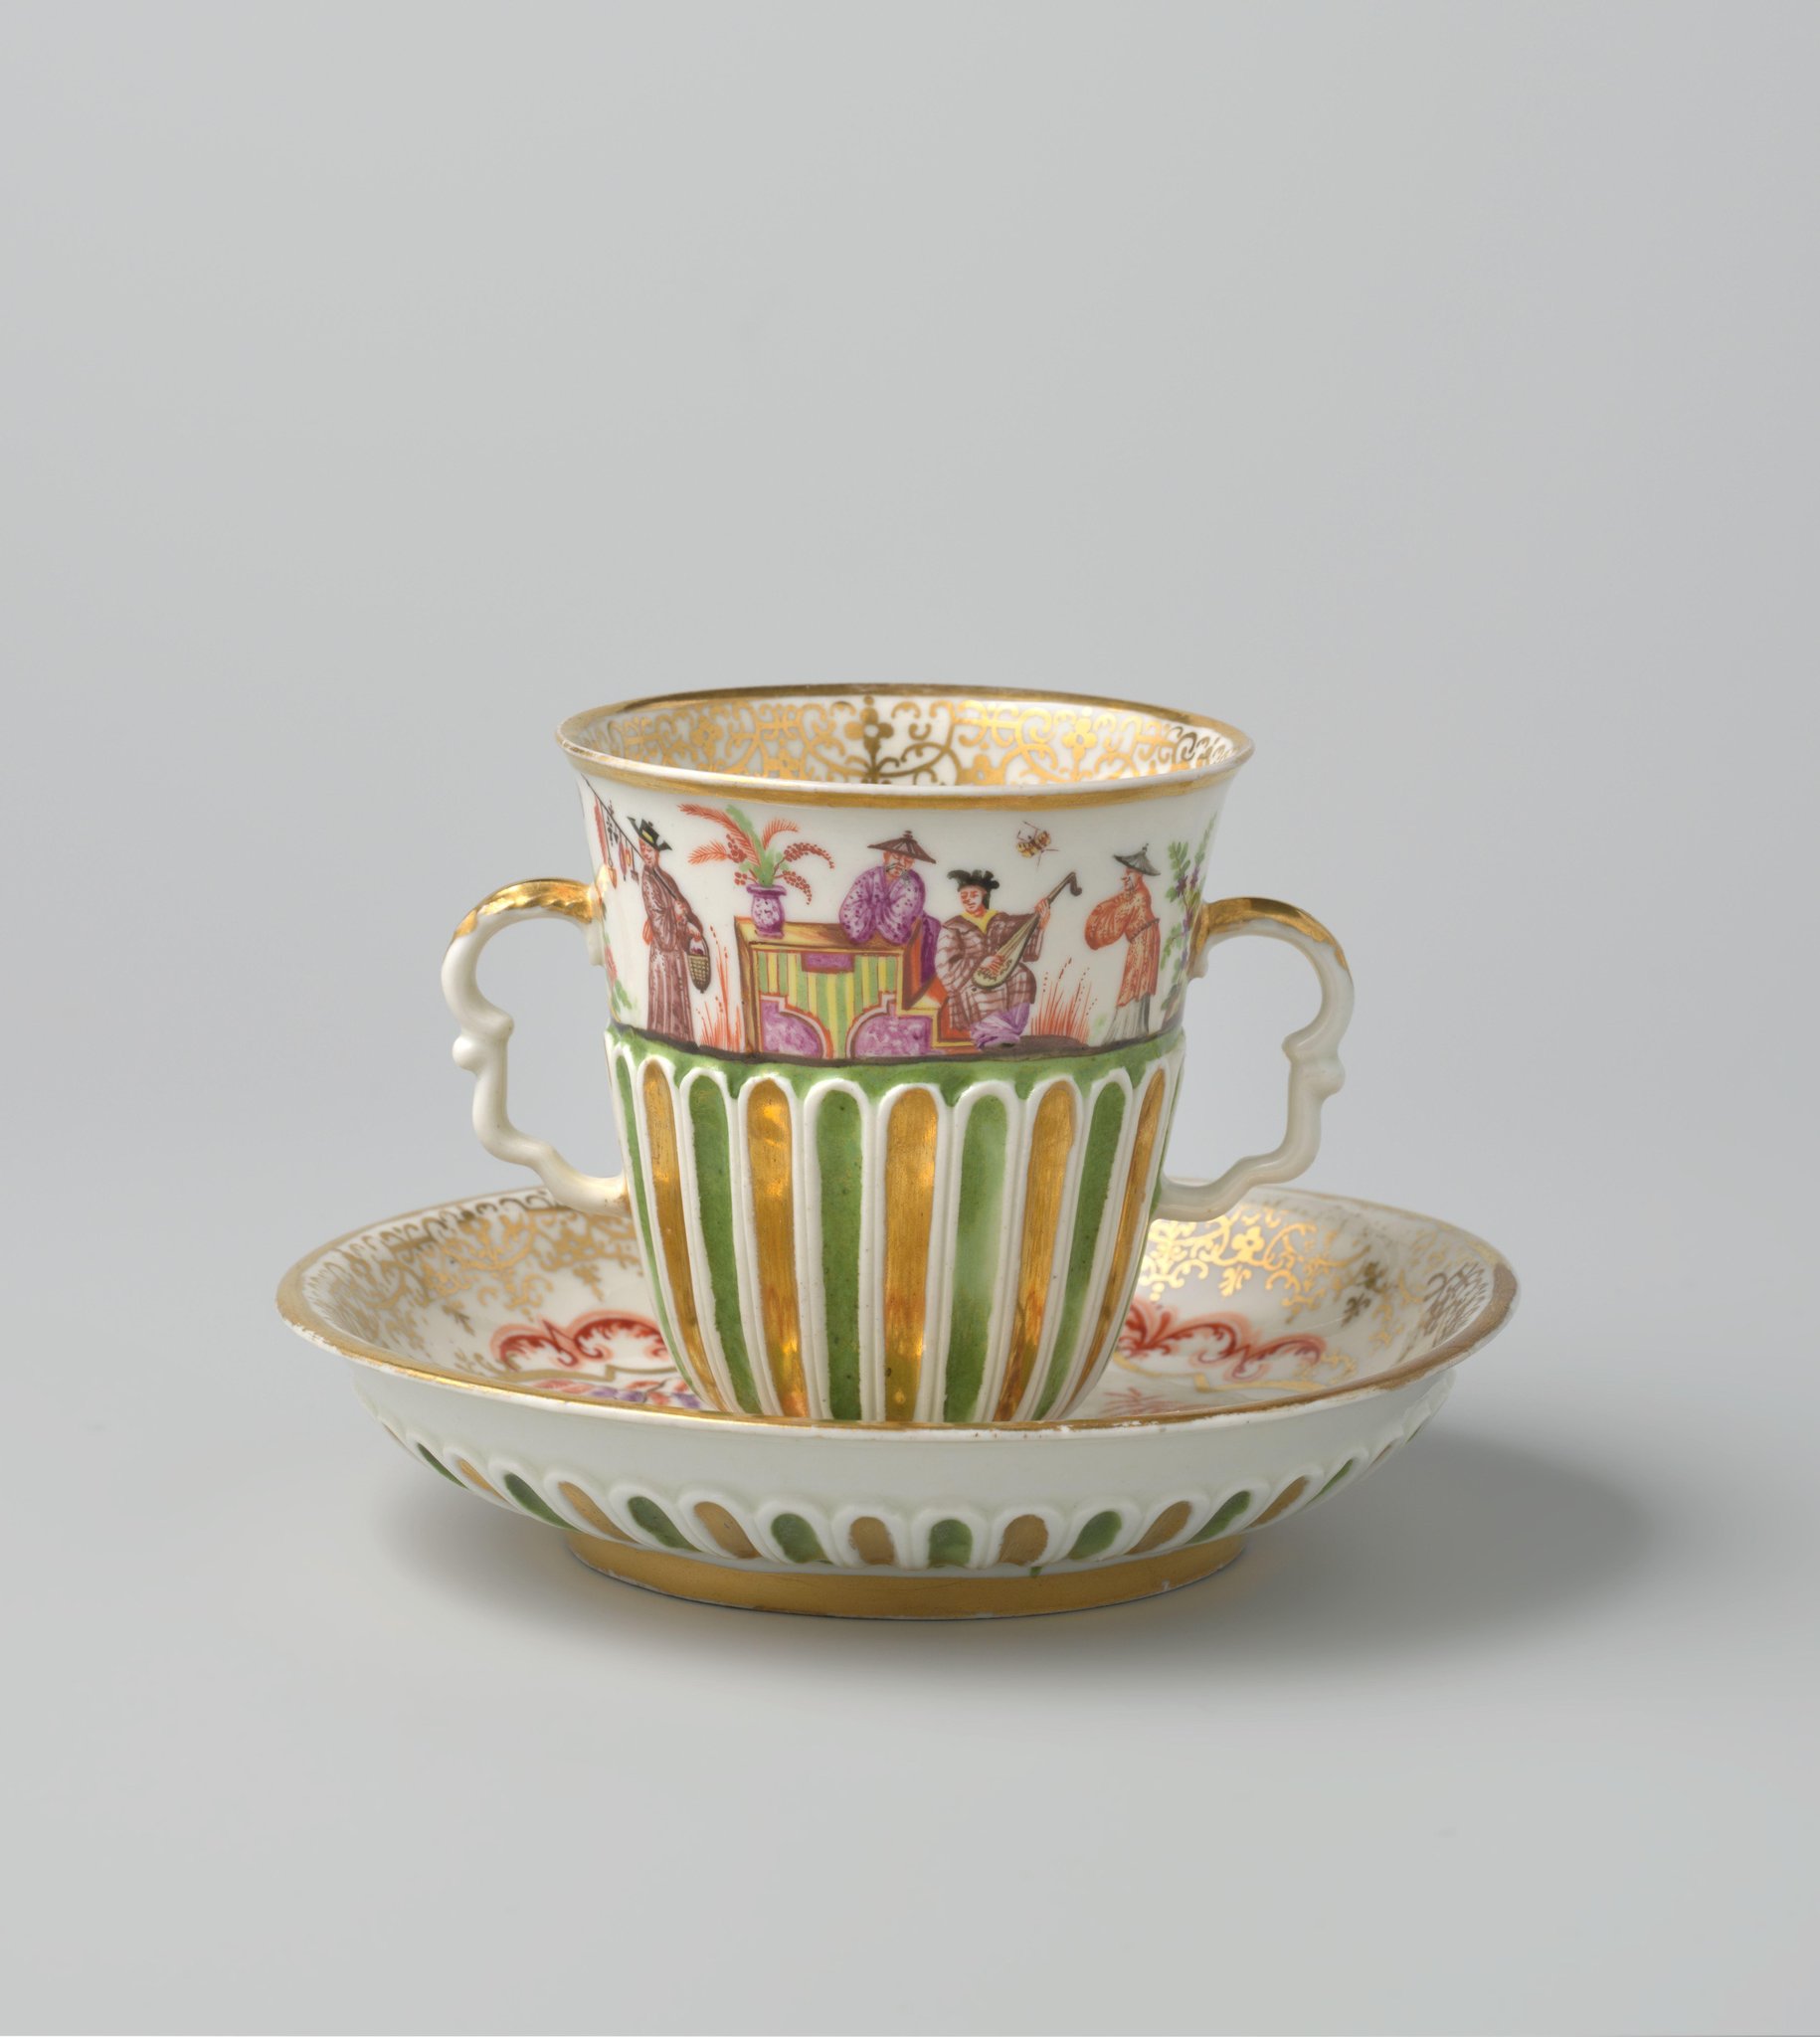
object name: kop en schotel, kop en schotel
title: Kop en schotel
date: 1728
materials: porcelain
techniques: gilding, painted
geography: meissen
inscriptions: number: ‘236’, number: ‘NK.3019’, number: ‘0152255’, label: ‘SAMMLUNG / Dr. FRANZ OPPENHEIMER’, number: ‘1953-a’, label: ‘SAMMLUNG / Dr. FRANZ OPPENHEIMER’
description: Schotel met chinoiserie-decoraties met twee figuren in een landschap rond een theepot op een vuur. Langs de randen bandwerk in rood en goud. Kop met cannelures aan de onderkant en twee oren. De cannelures zijn afwisselend groen en goud ingekleurd. Op de sectie daarboven een doorlopend chinoiserie-decor met figuren in een groen landschap.